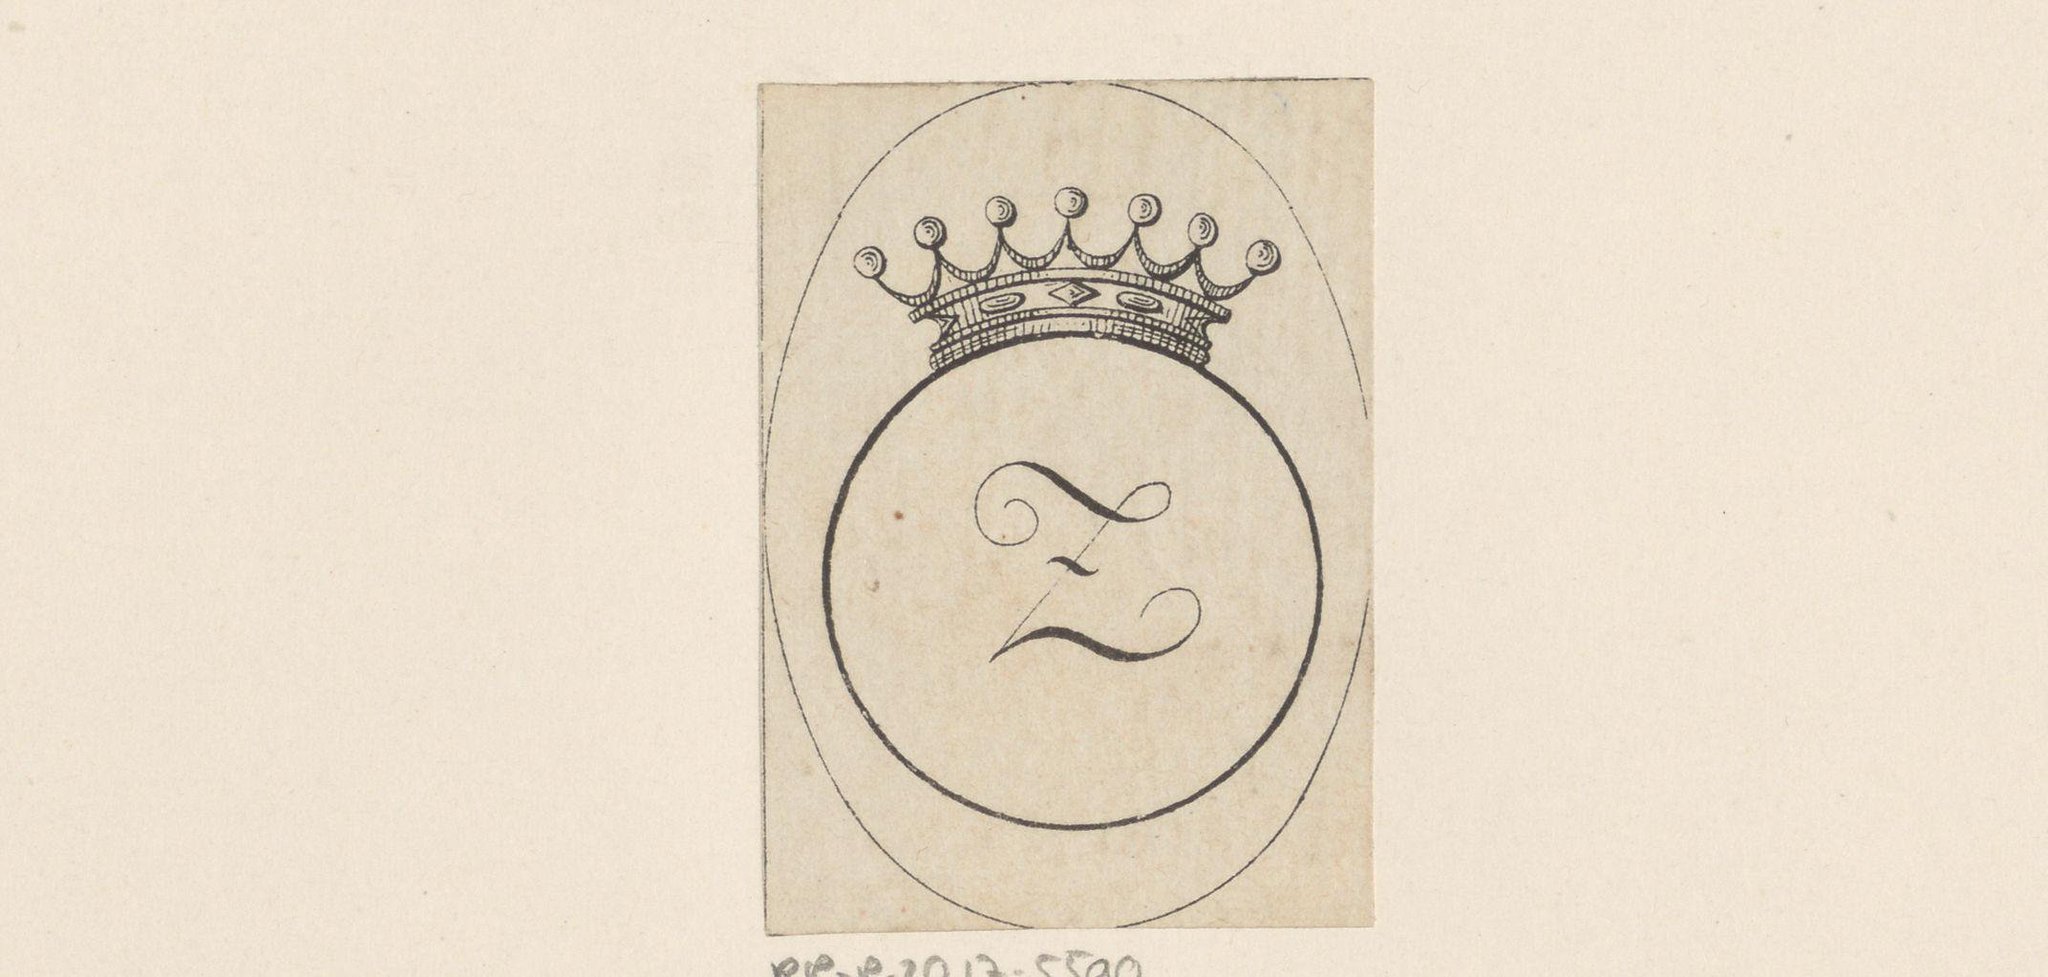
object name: bookplate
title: Ex libris van Z.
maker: Anonymous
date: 1800-1899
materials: paper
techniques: lithograph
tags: crown (symbol of sovereignty)